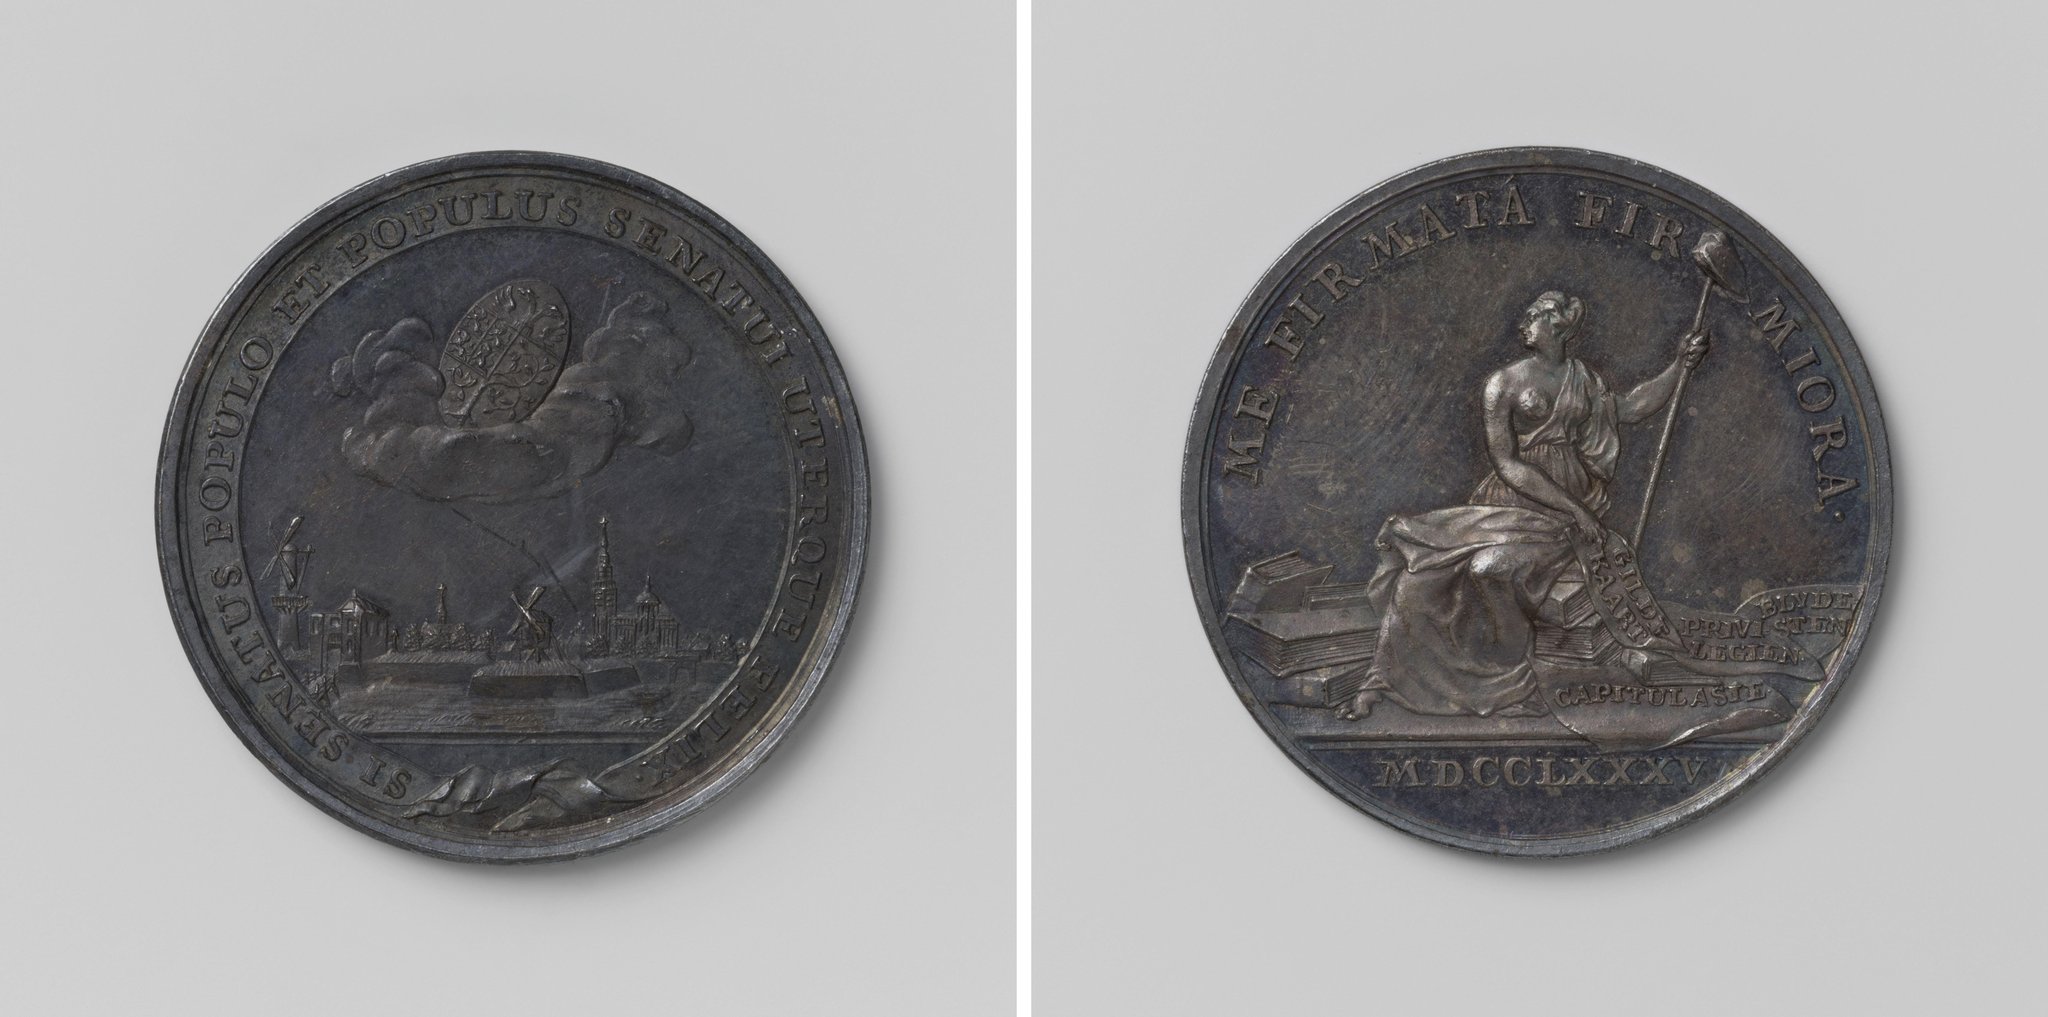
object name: council medal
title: Vroedschapspenning van de stad 's-Hertogenbosch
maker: theodorus victor van berckel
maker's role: mintmaster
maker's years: 1739-1808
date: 1785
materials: silver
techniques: striking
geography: den bosch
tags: den bosch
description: Zilveren penning. Voorzijde: gezicht op stad vanaf de zuidzijde onder wolken, waarop wapenschild rust binnen omschrift op lint. Keerzijde: zittende, naar links gewende vrouw met vrijheidshoed op speer, voorstellende stad 's-Hertogenbosch, wijst met rechterhand op stapel boeken en papieren aan haar voeten binnen omschrift; afsnede: jaartal.